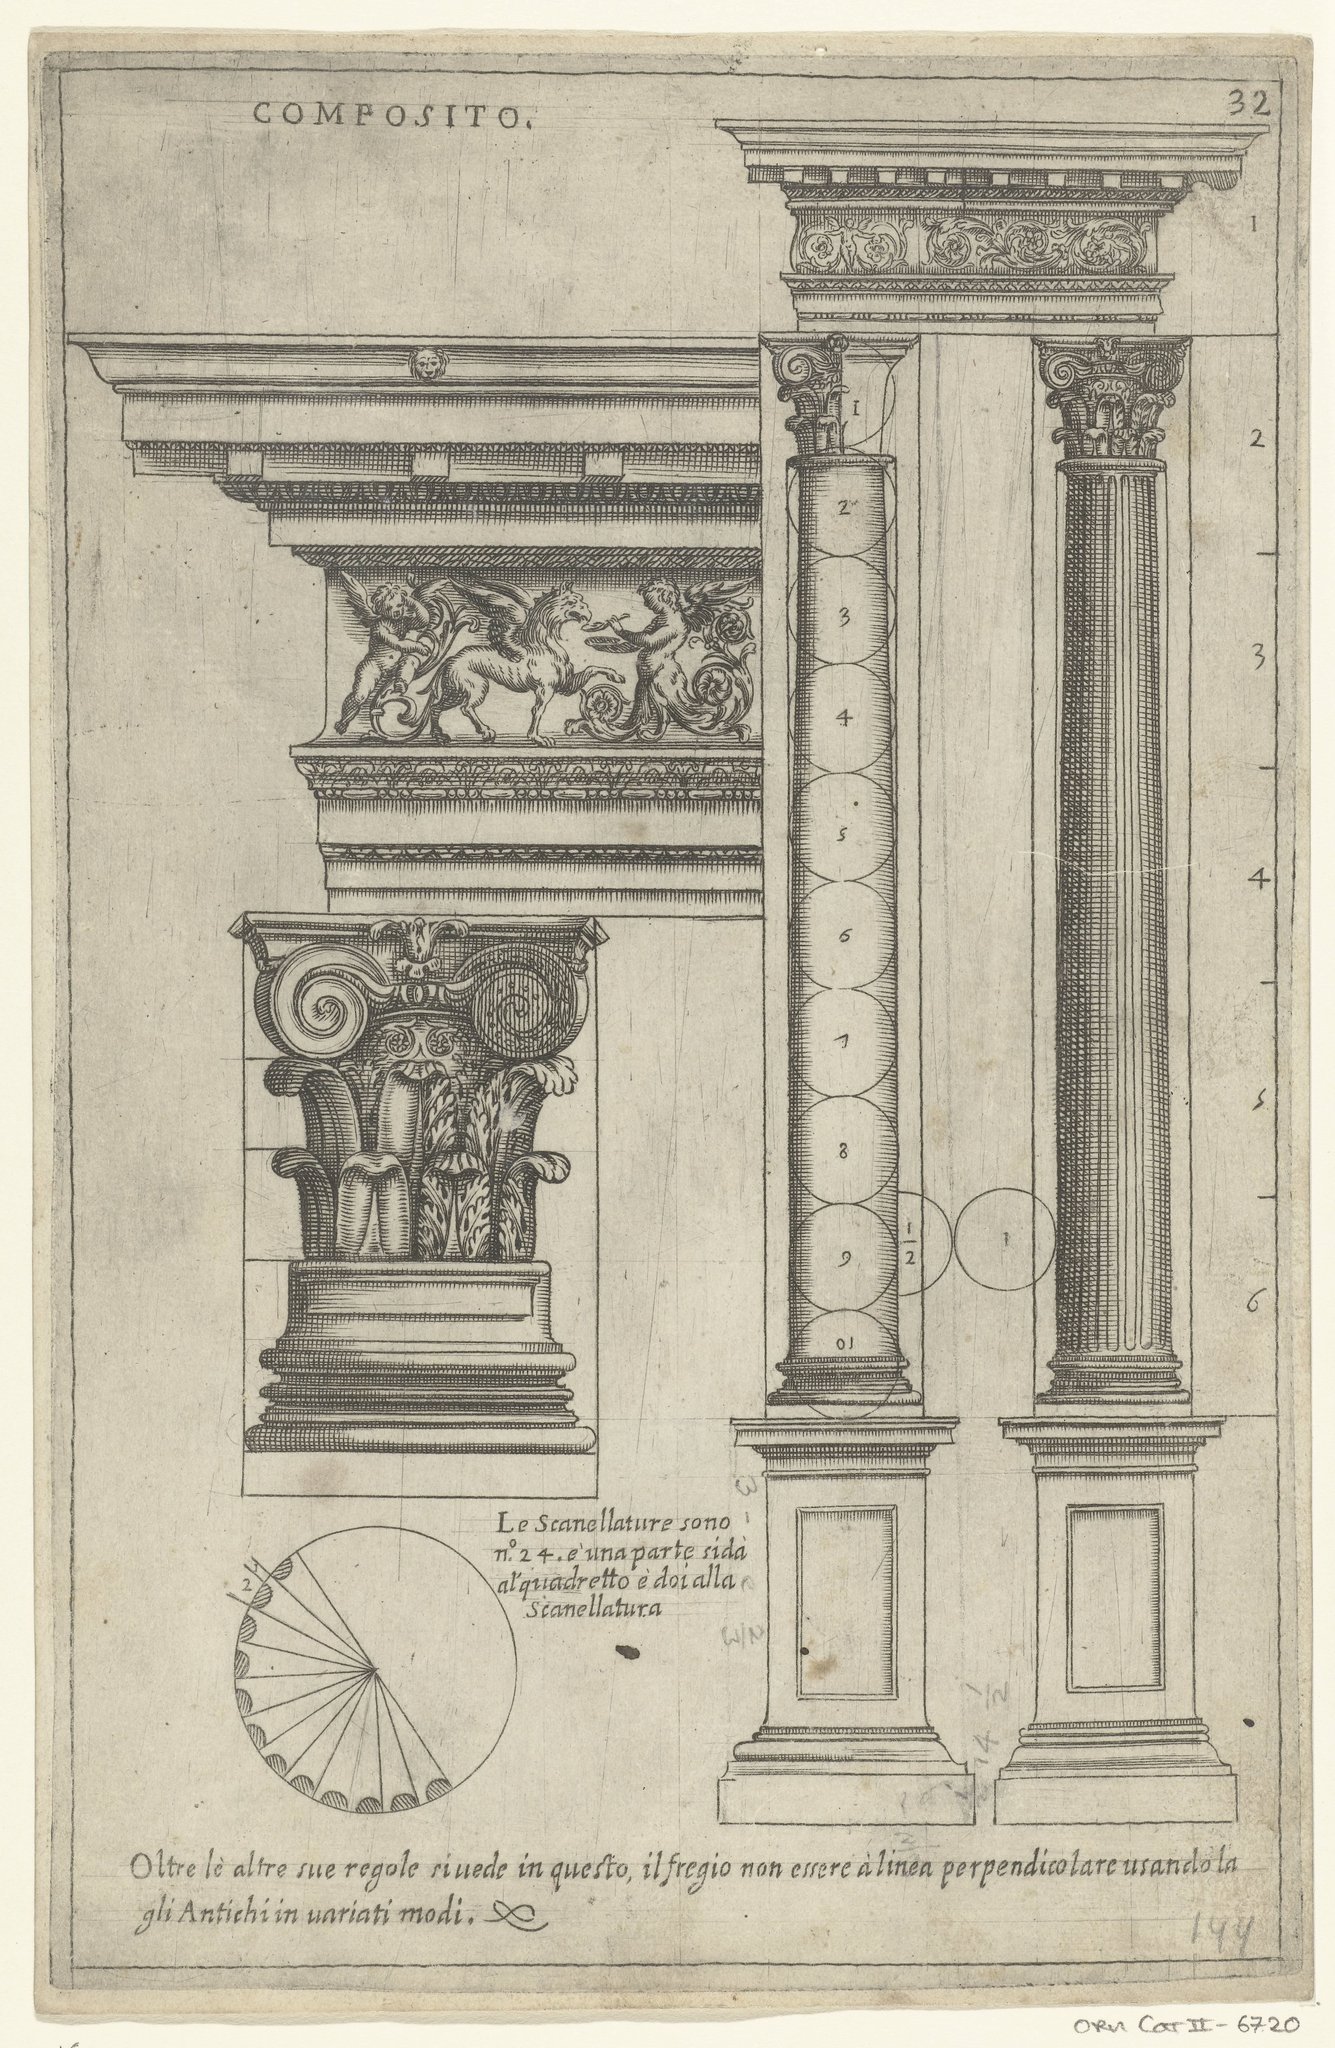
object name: print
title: Twee Composietzuilen met voetstukken, kapitelen, een hoofdgestel en details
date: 1636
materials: paper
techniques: engraving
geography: rome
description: Links staan details afgebeeld van het hoofdgestel, kapiteel, basement en een doorsnede van de schacht.